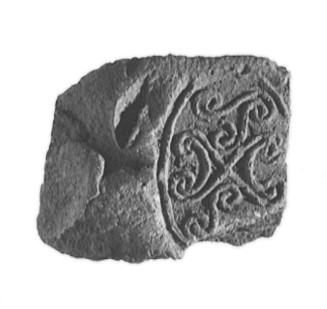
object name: sealing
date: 2030-1640 BCE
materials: clay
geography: egypt